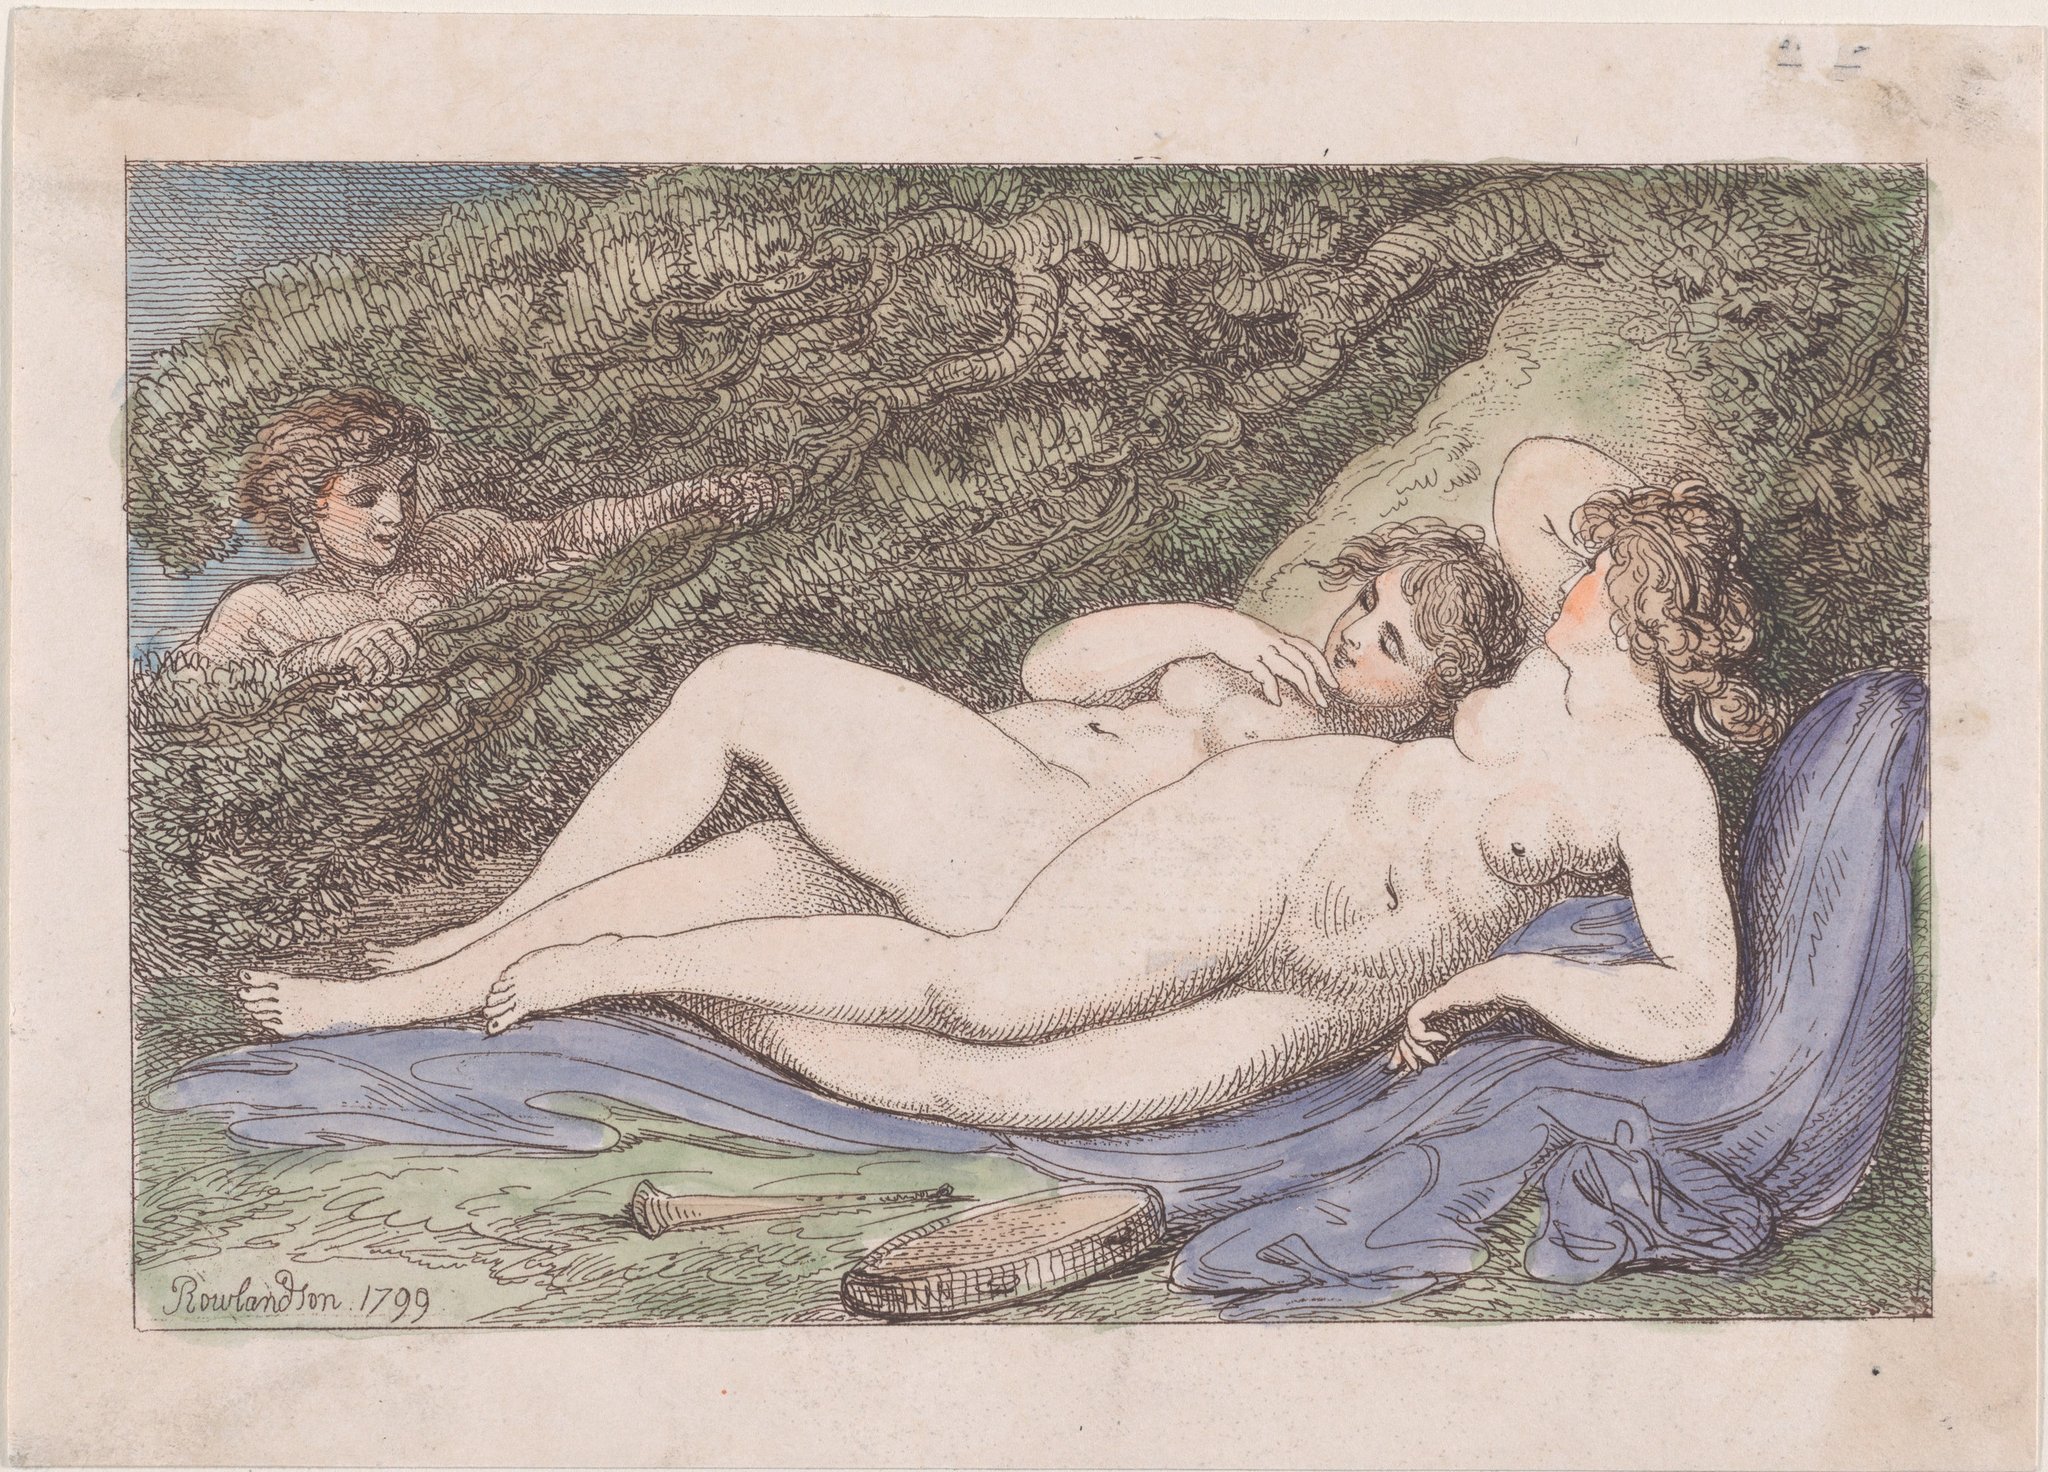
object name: print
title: Wood-Nymphs (The Discovery)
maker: thomas rowlandson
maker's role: artist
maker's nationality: british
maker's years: 1757-1827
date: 1799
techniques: etching, stippling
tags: men,female nudes